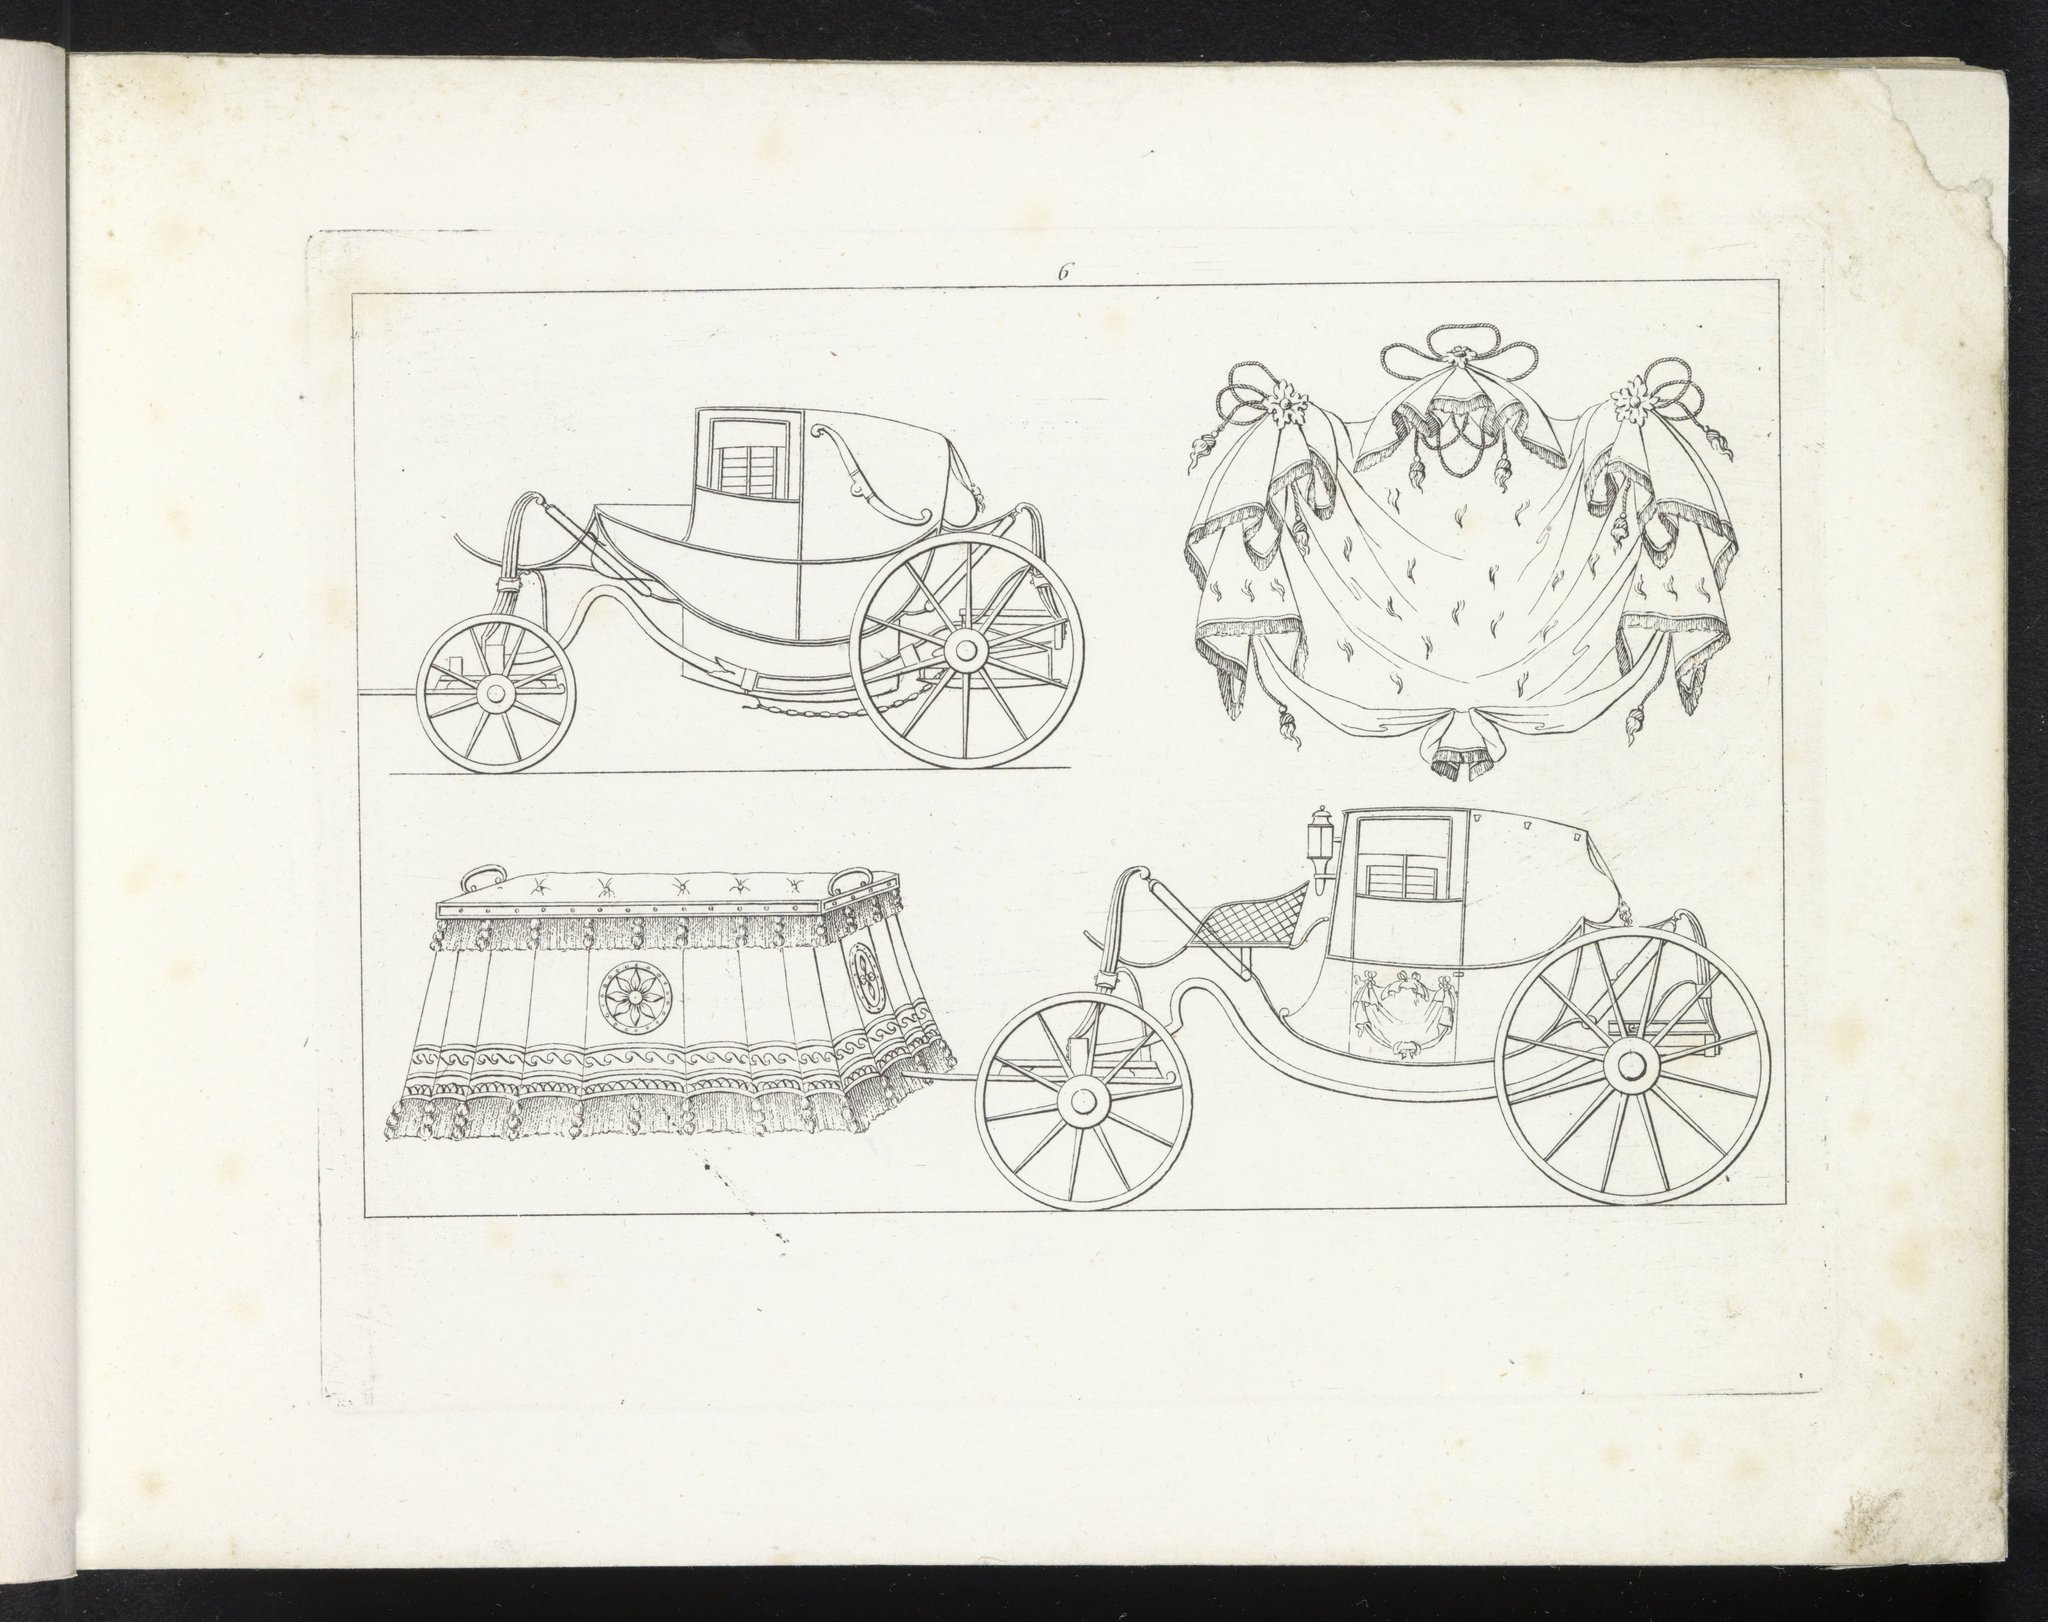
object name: print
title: Ontwerpen voor religieuze en profane voorwerpen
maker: pietro ruga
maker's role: print maker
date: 1817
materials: paper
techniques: etching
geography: milan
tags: ornaments ~ art, (story of) minerva (pallas, athena), (story of) mercury (hermes), fates, parcae (moirae), clock, father time, man with wings and scythe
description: Links een klok met Minerva, Mercurius en Vadertje Tijd. Rechts een klok met de drie schikgodinnen. Prent maakt deel uit van een album.